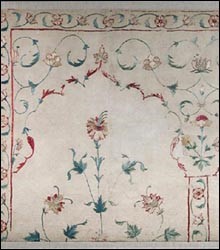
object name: textile fragment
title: Embroidered Textile Fragment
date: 1701-1800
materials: cotton, silk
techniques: embroidery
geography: india